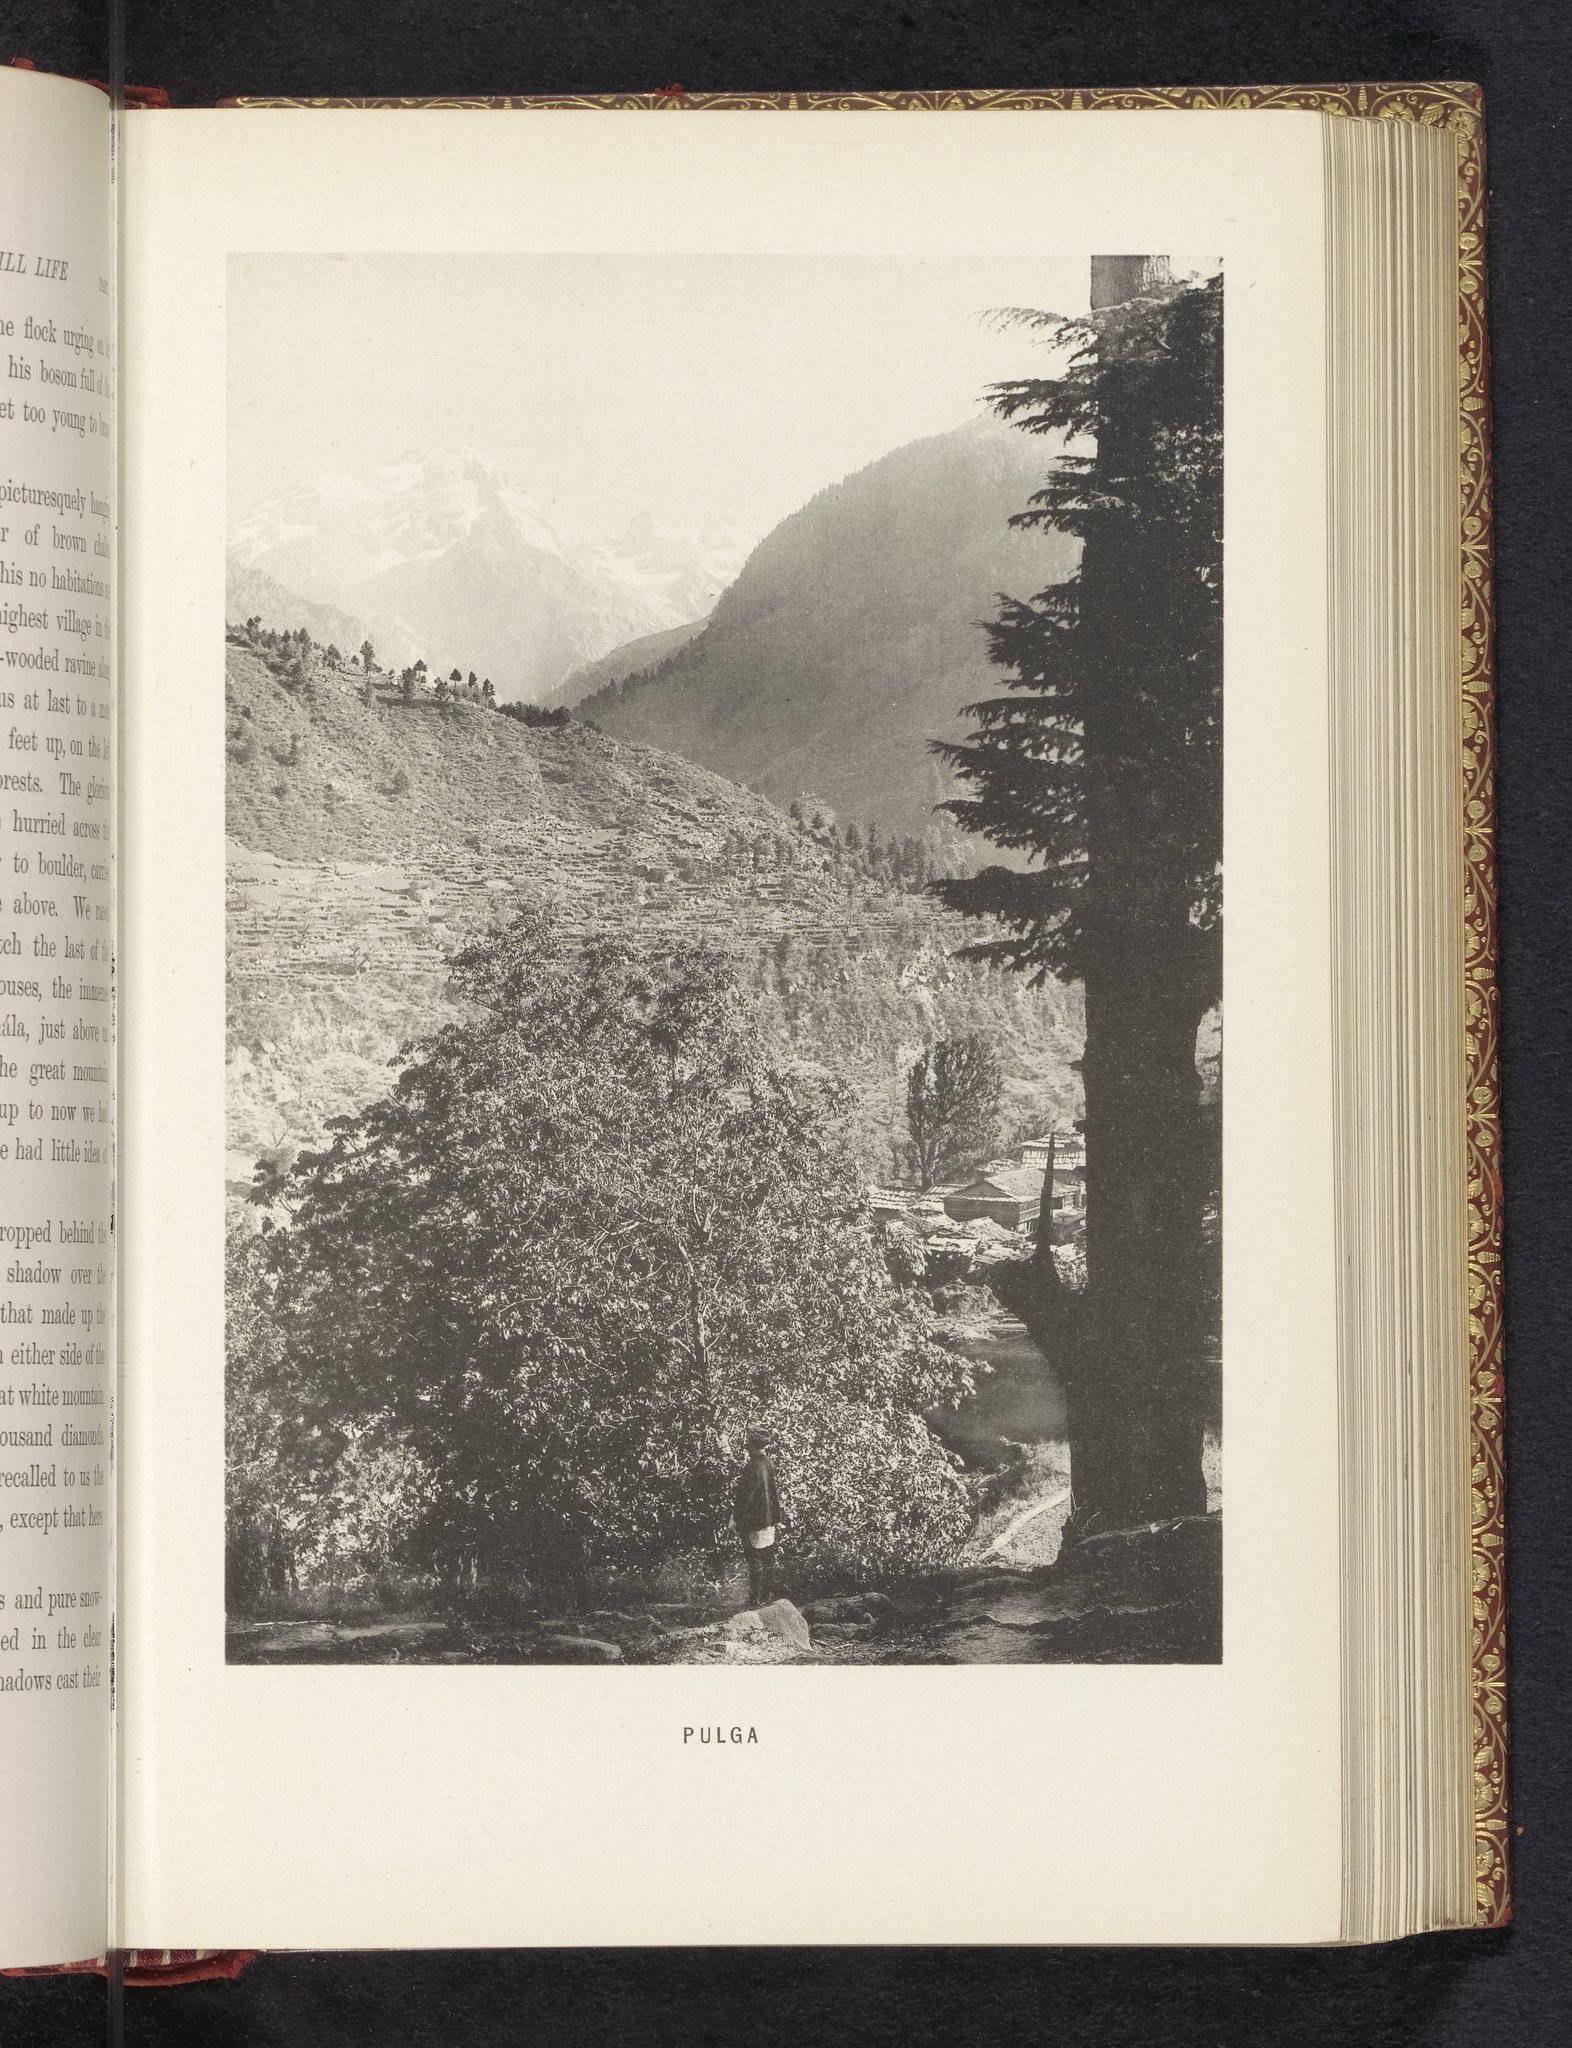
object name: photomechanical print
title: View of the Parvati valley at Pulga, Himachal Pradesh, India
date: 1890-1895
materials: paper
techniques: photograph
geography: parvati valley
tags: dale, valley, city-view in general; 'veduta'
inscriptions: caption: ‘PULGA’